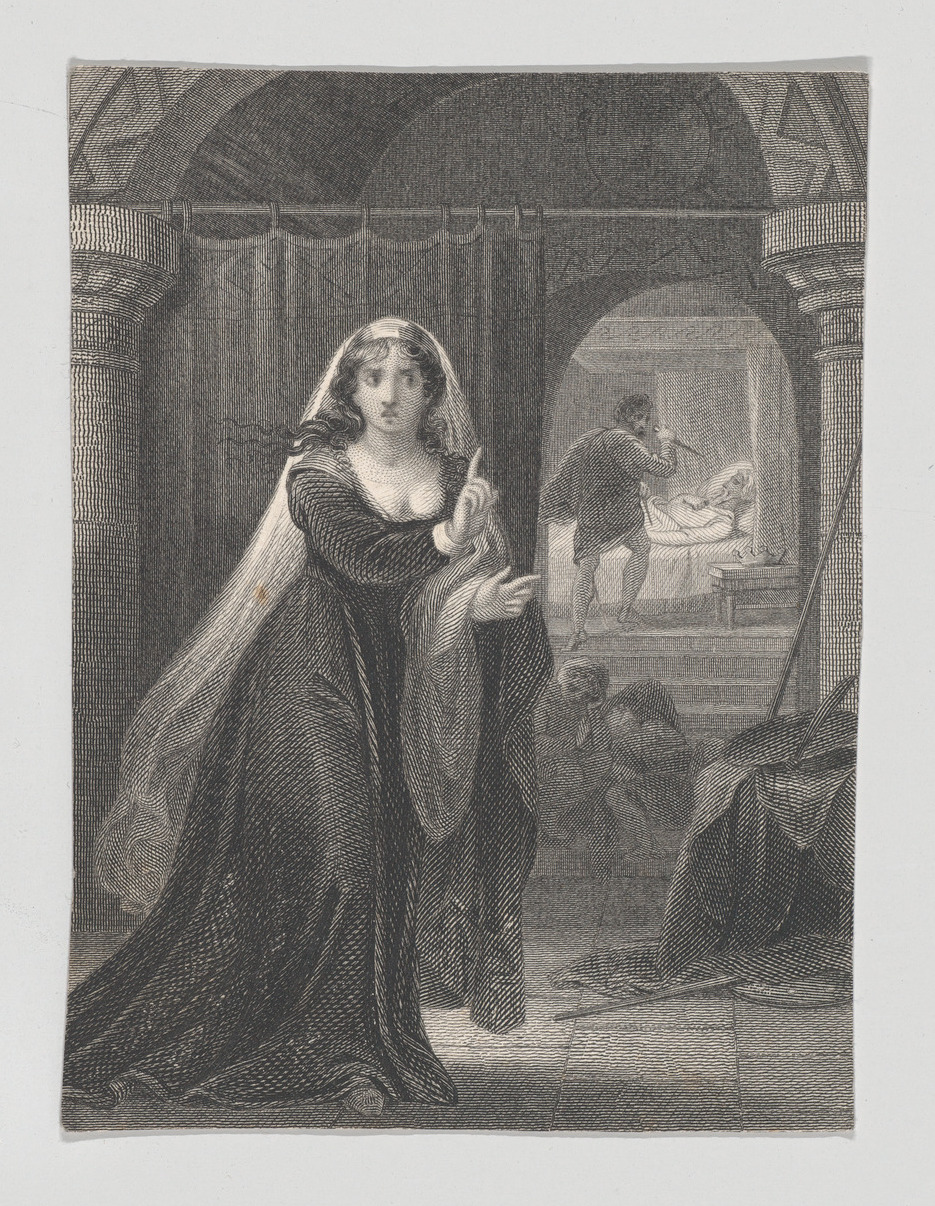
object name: print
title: Lady Macbeth, Macbeth and the Murder of Duncan (Shakespeare, Macbeth, Act II, Scene II)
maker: charles rolls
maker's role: engraver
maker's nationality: british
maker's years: 1799-1885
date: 1825-1840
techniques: engraving, etching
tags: shakespeare,men,women,macbeth